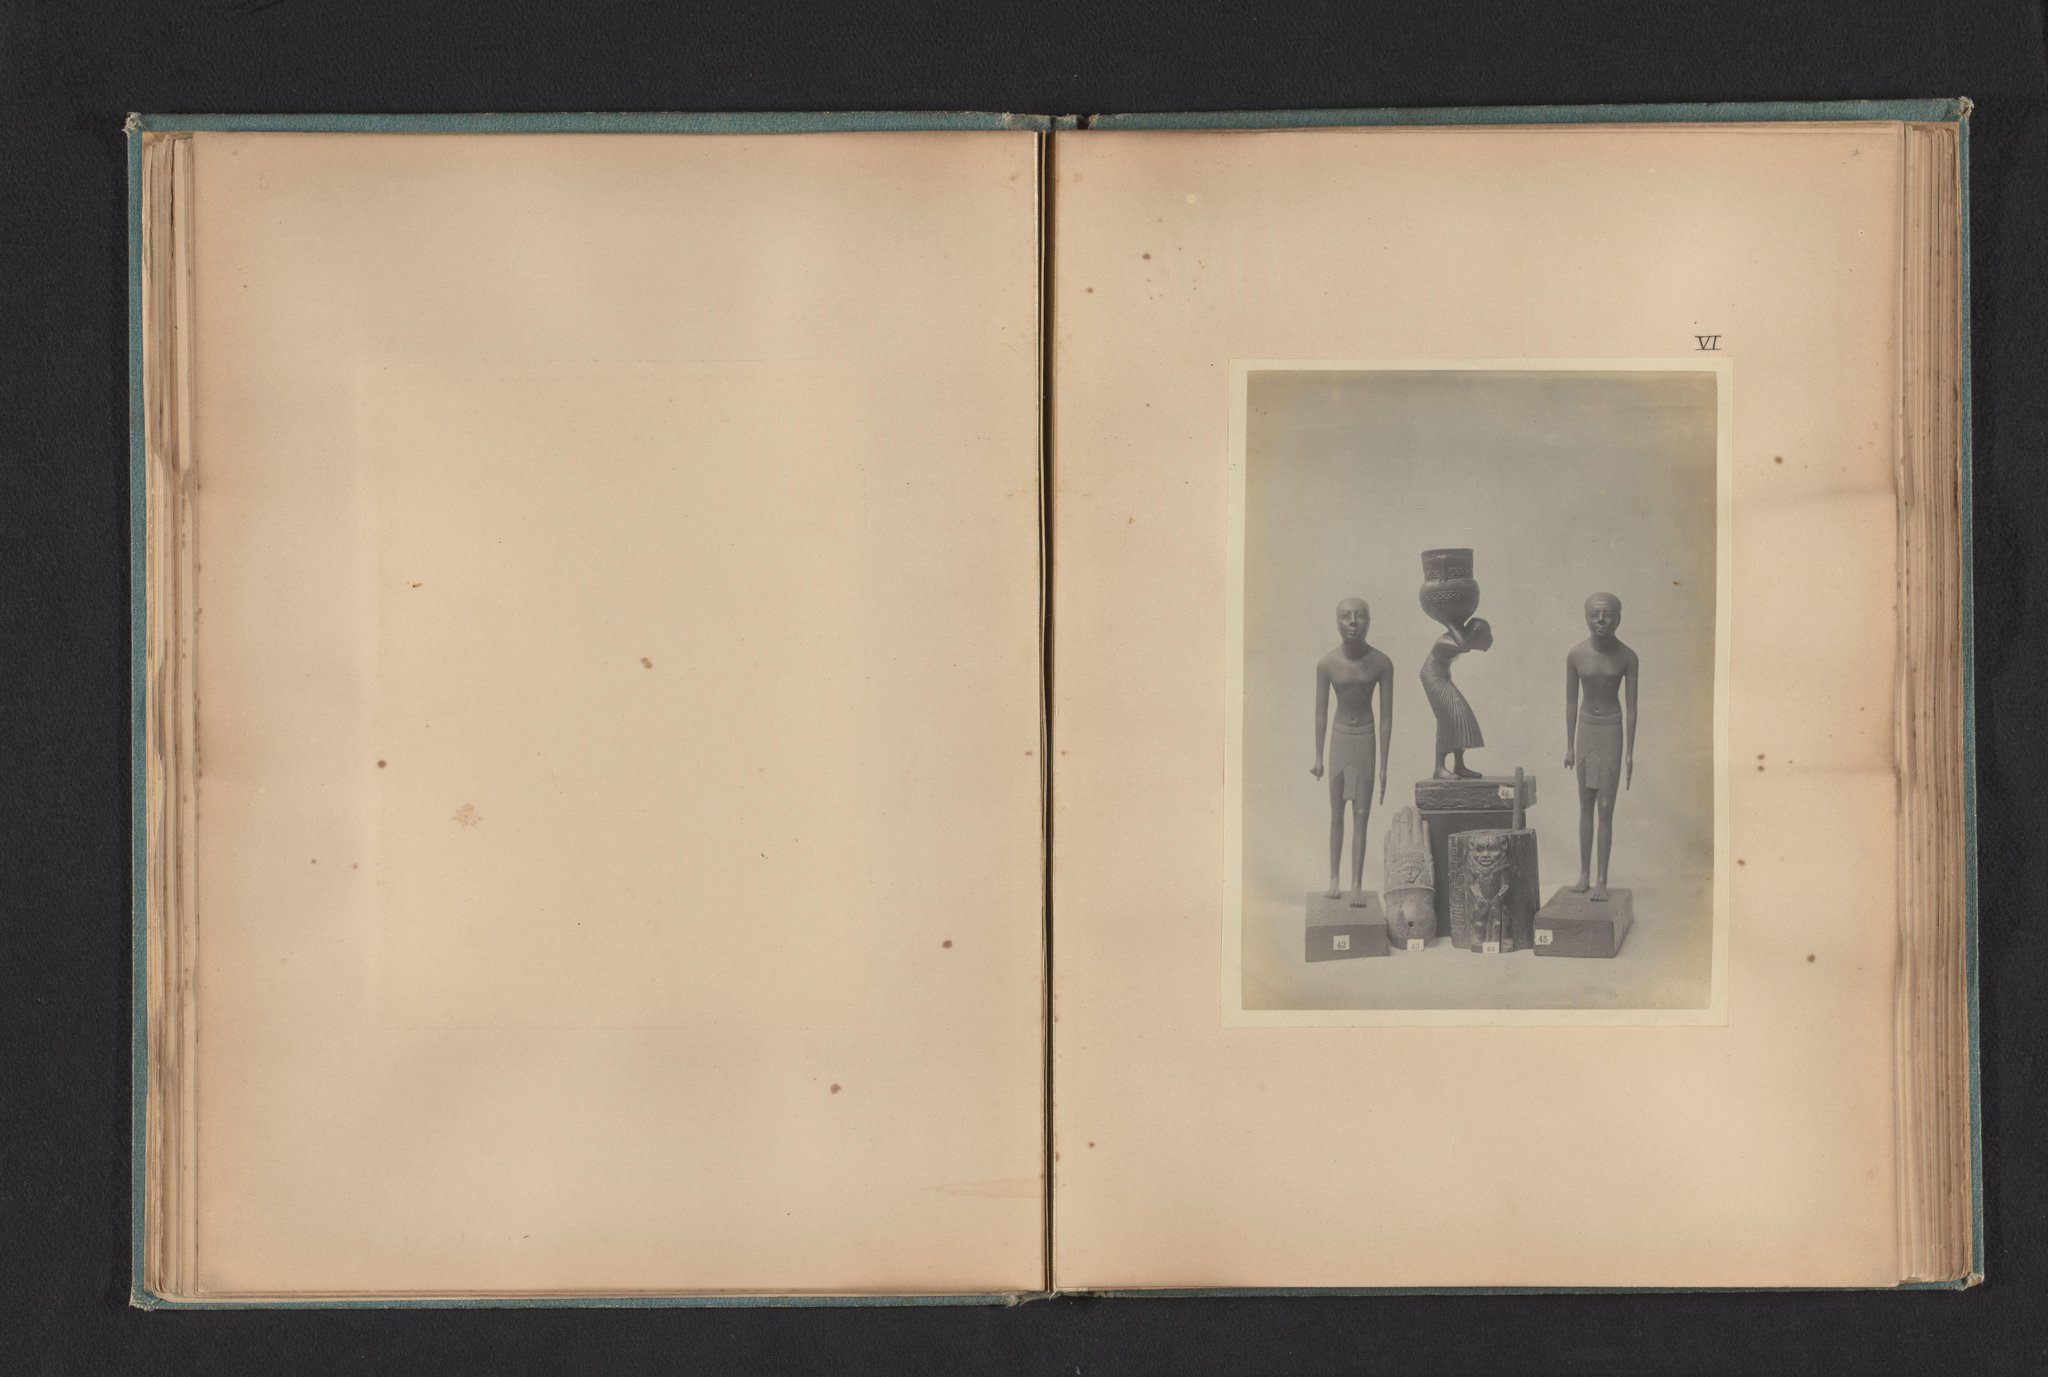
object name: page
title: Vijf Egyptische objecten, waaronder twee sculpturen van jongens en een houten kohlpot met de afbeelding van Bes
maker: Anonymous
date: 1890-1895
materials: photographic support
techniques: gelatin silver print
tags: wooden container: barrel, cask, bucket, representations ~ egyptian gods, demi-gods, heroes, etc. (bes), youth, adolescent, sculpture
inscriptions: number: ‘VI’